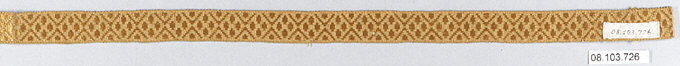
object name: galloon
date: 1801-1900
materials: silk